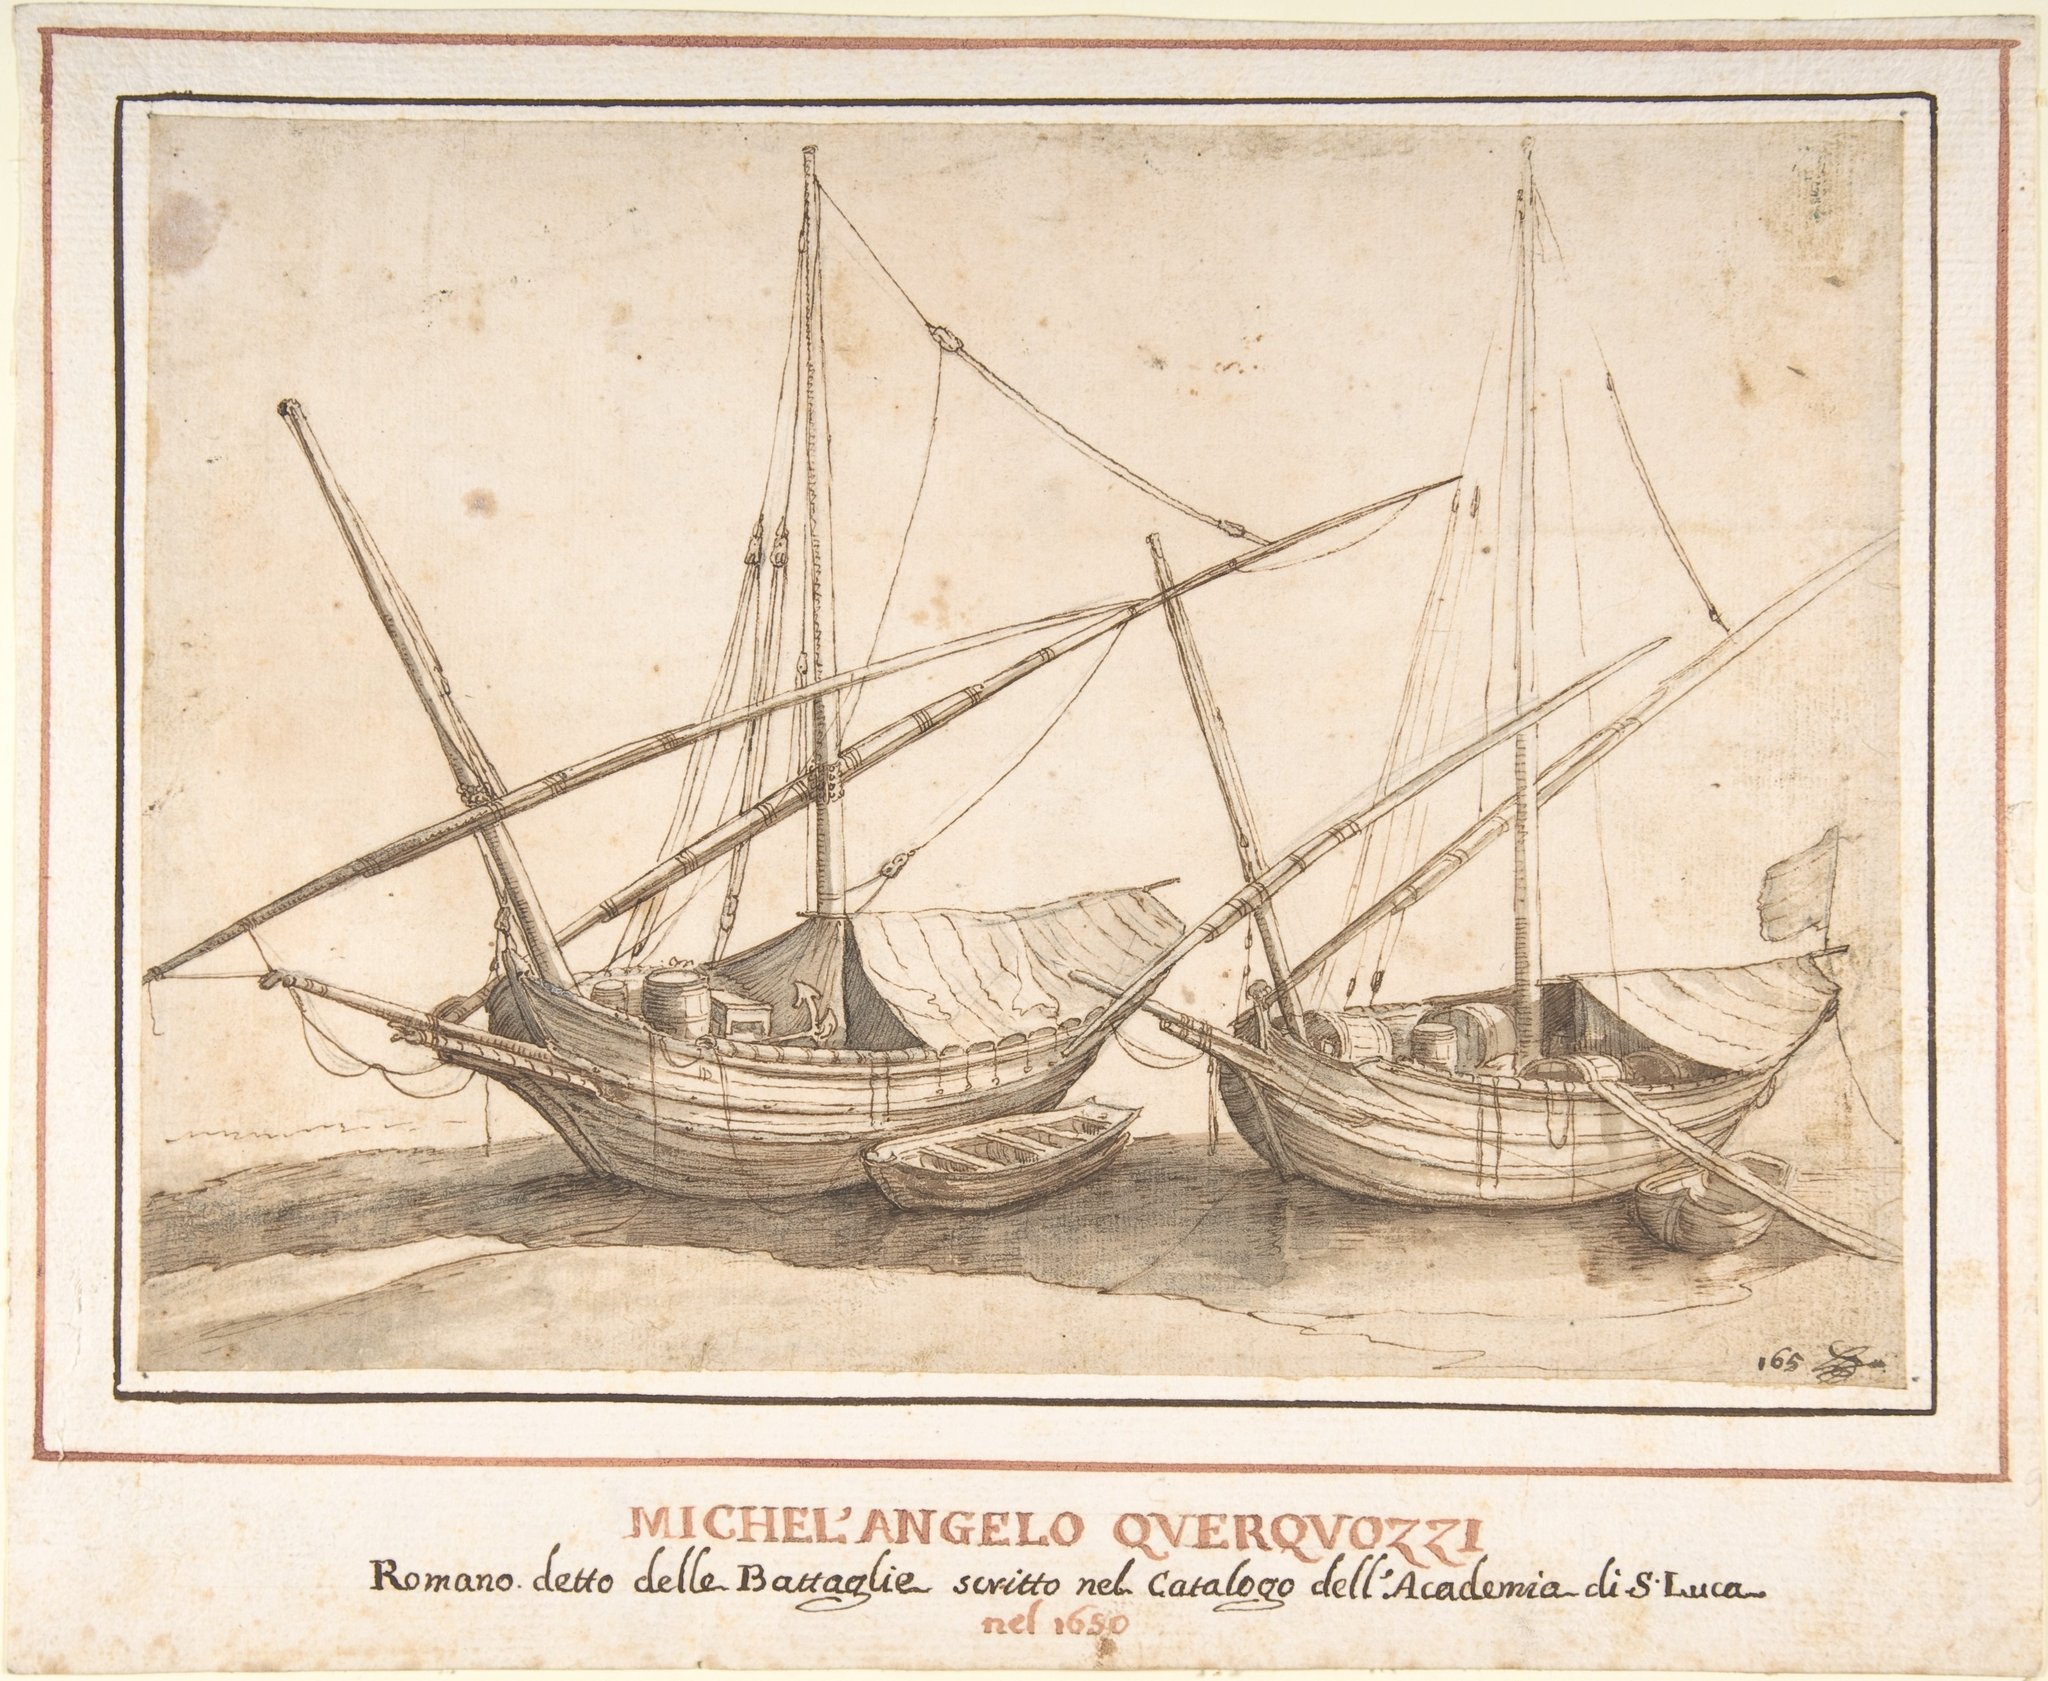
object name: drawing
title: Four Boats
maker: michelangelo cerquozzi (michelangelo delle battaglie)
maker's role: artist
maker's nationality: italian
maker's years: 1602-1660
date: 1602-1660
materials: chalk, ink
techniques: brush, pen, wash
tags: boats